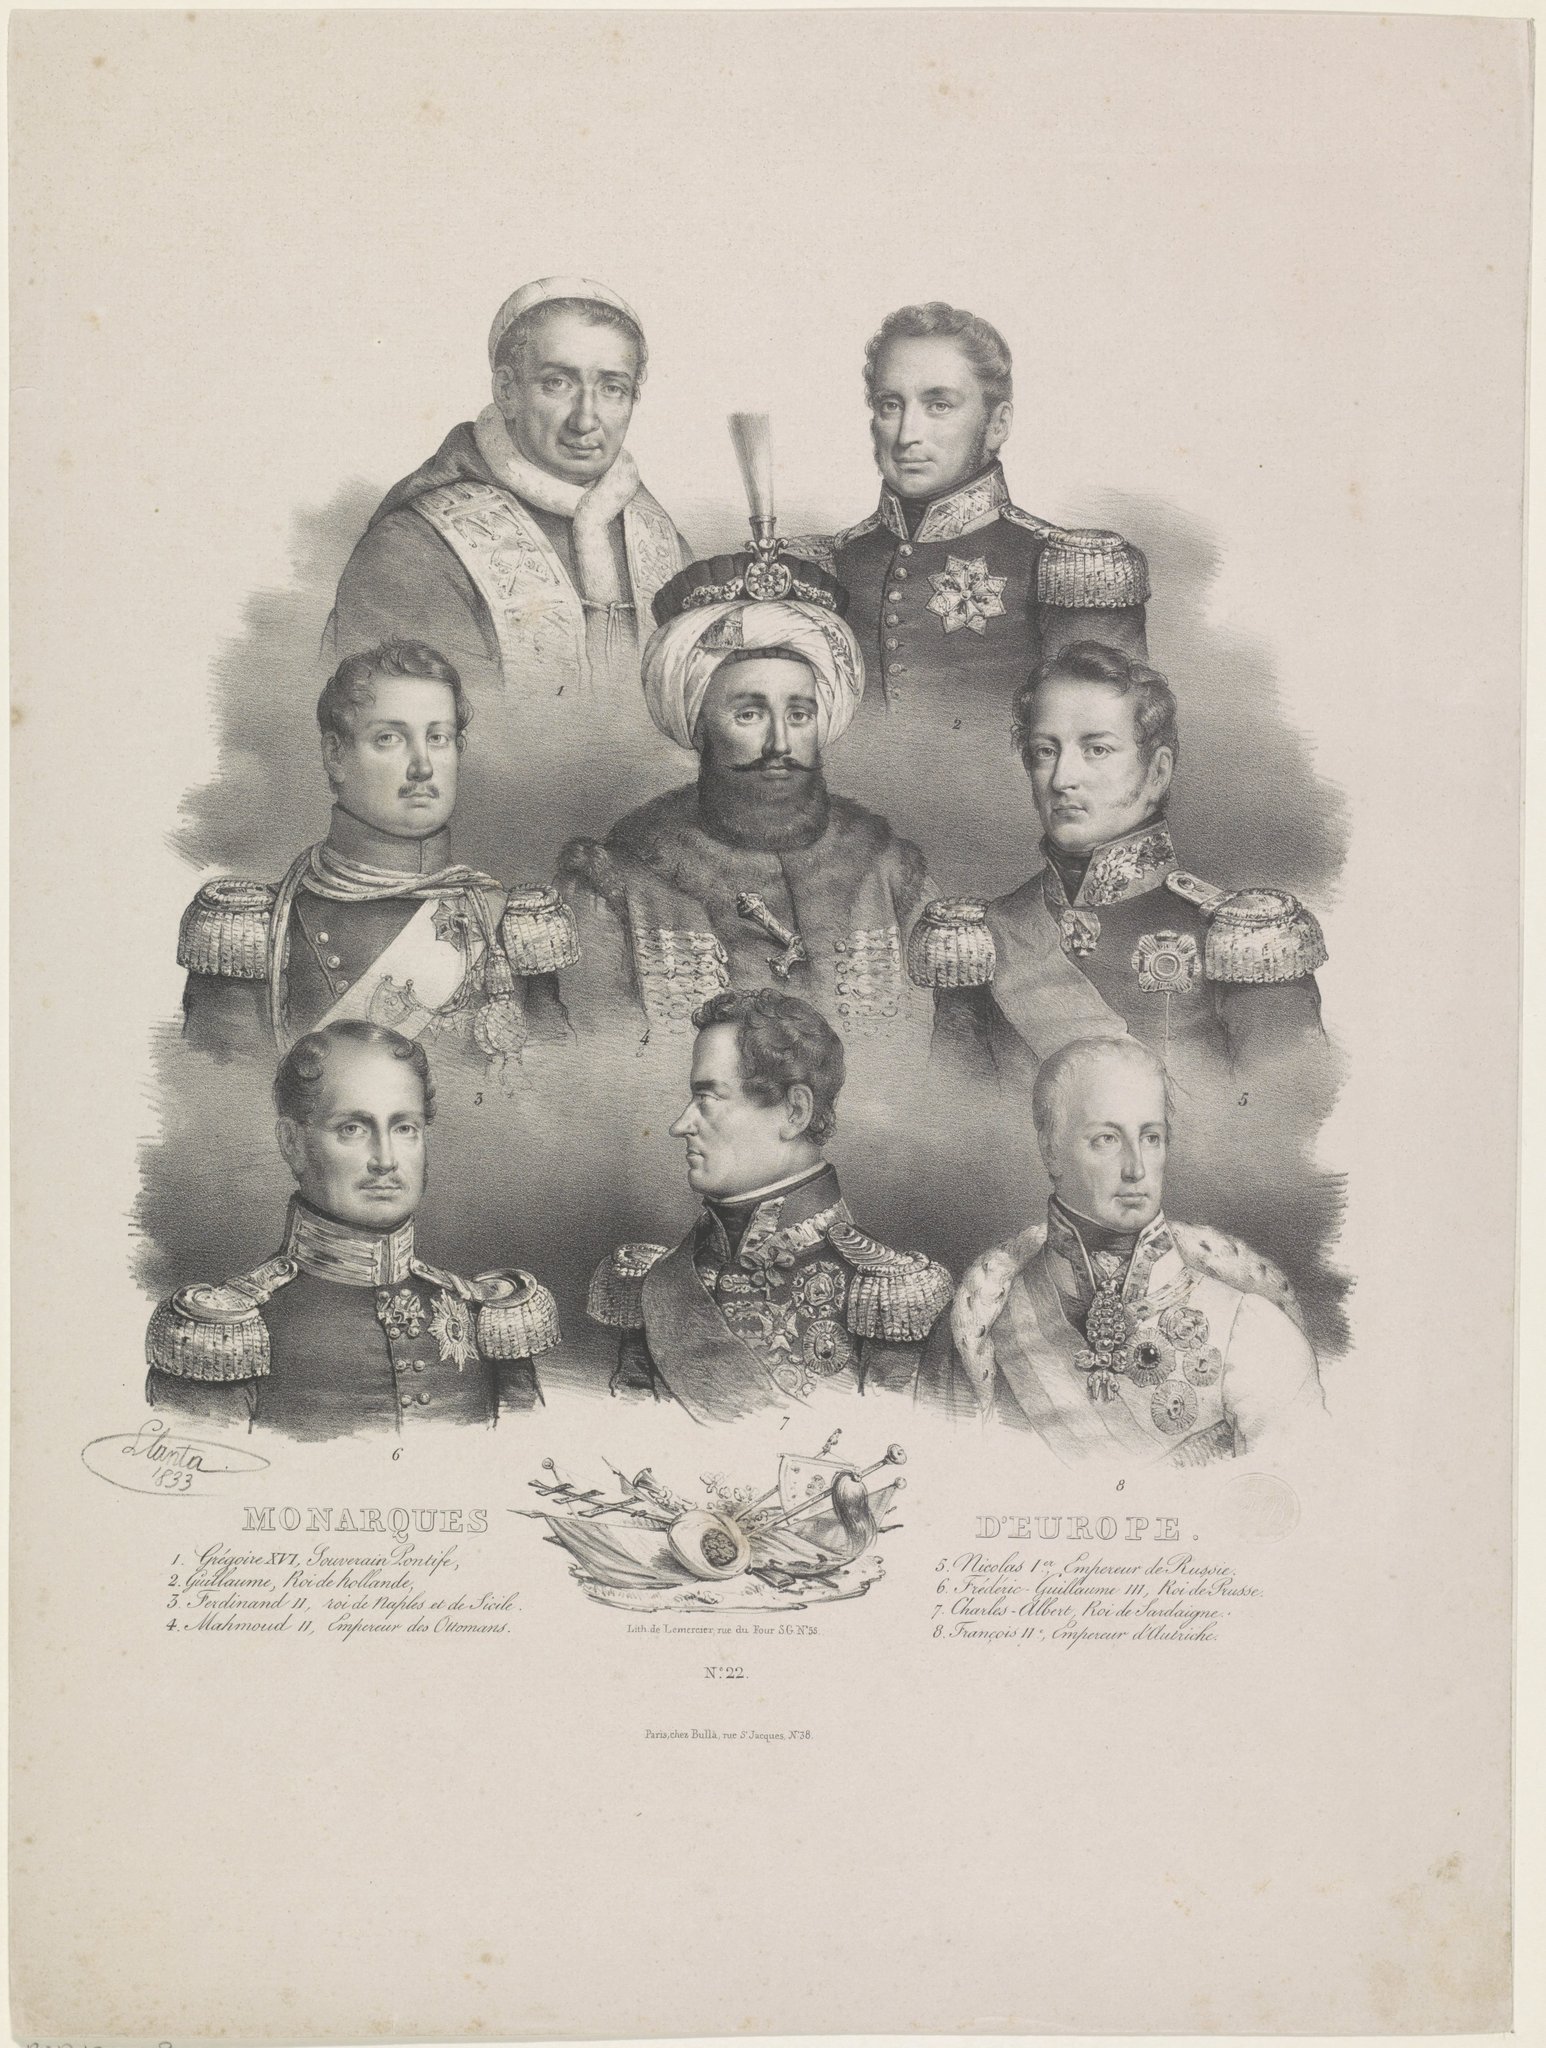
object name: print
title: Portretten van beroemde personen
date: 1833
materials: paper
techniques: lithograph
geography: france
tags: rome, the hague, berlin, william i of the netherlands, caserta, vienna, frans ii (rooms-duits keizer), frederik willem iii koning van pruisen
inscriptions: collector's mark: Lugt 2228, check stamp: ‘FB’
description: Portretten van paus Gregorius XVI, Willem I (koning der Nederlanden), Ferdinand II (koning der Beide Siciliën), Mahmut II (sultan van het Ottomaanse Rijk), Nicolaas I Pavlovitsj (tsaar van Rusland), Frederik Willem III (koning van Pruisen), Karel Albert (koning van Sardinië) en Frans II (Rooms-Duits keizer).. Linksonder en rechtsonder een verklarende lijst.